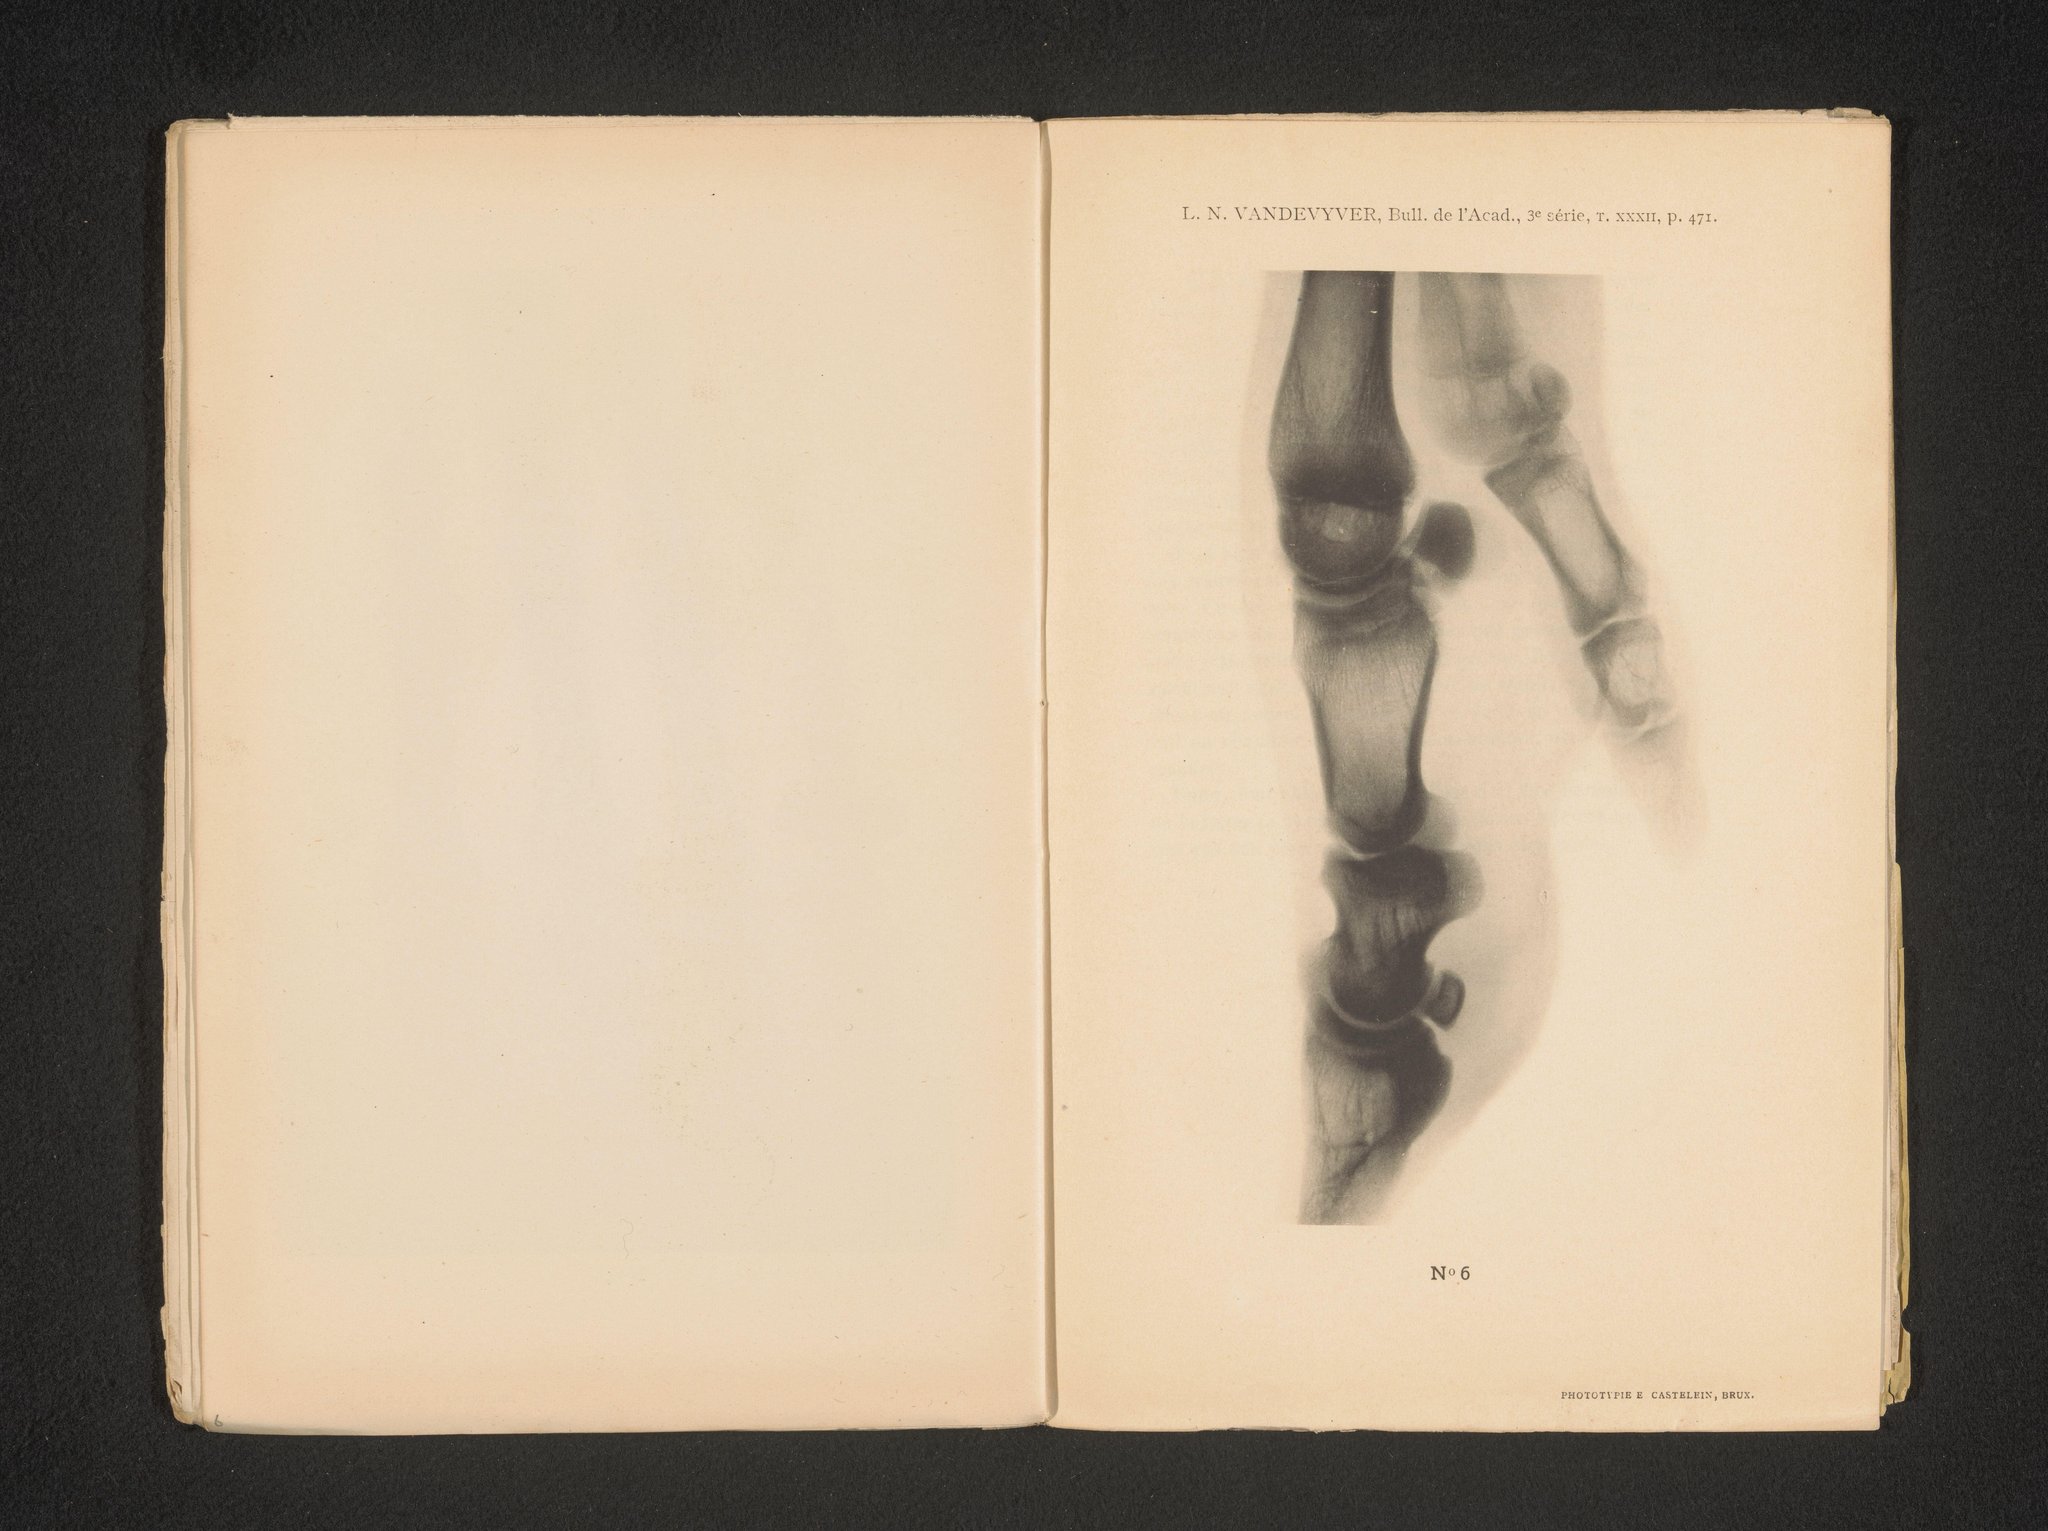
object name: page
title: Röntgenfoto van een poot van een varken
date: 1891-1896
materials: paper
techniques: photograph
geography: ghent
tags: x-ray examination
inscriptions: number: ‘No 6’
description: Prent op vijfde ongenummerde pagina na pagina 470.